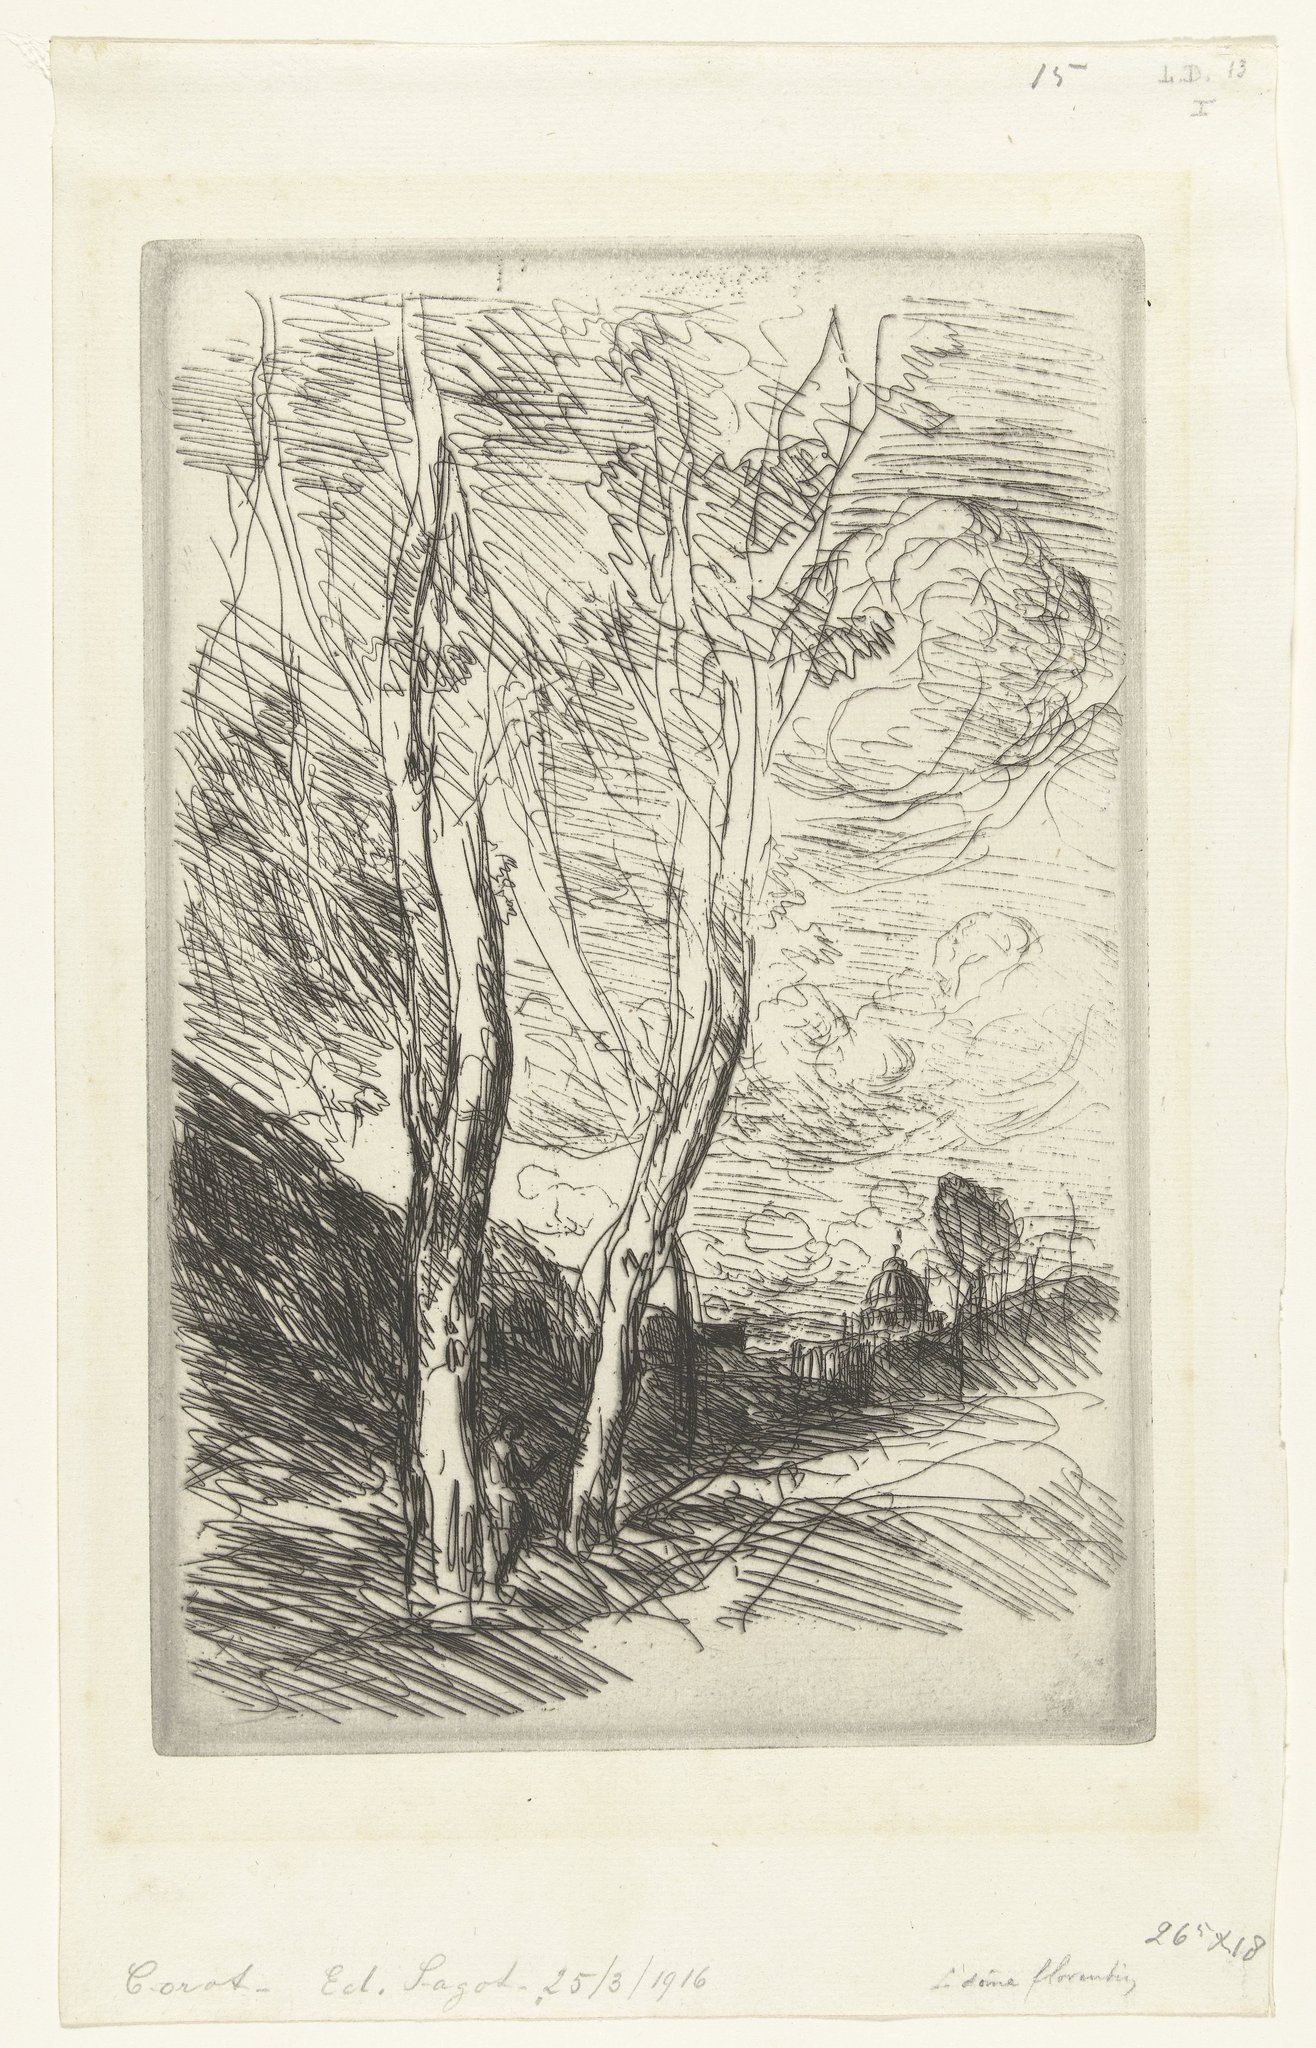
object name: print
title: Italiaans landschap met vergezicht met kerk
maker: camille corot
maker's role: draughtsman, painter, print maker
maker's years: 1796-1875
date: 1869-1870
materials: paper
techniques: etching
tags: trees, (high) hill, church (exterior)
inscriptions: collector's mark: Lugt 2228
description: In een heuvellandschap staat een groepje bomen op de voorgrond links met daaronder een staande figuur, misschien een tekenaar. Rechts in de verte ligt een kerk met een grote koepel op het dak.